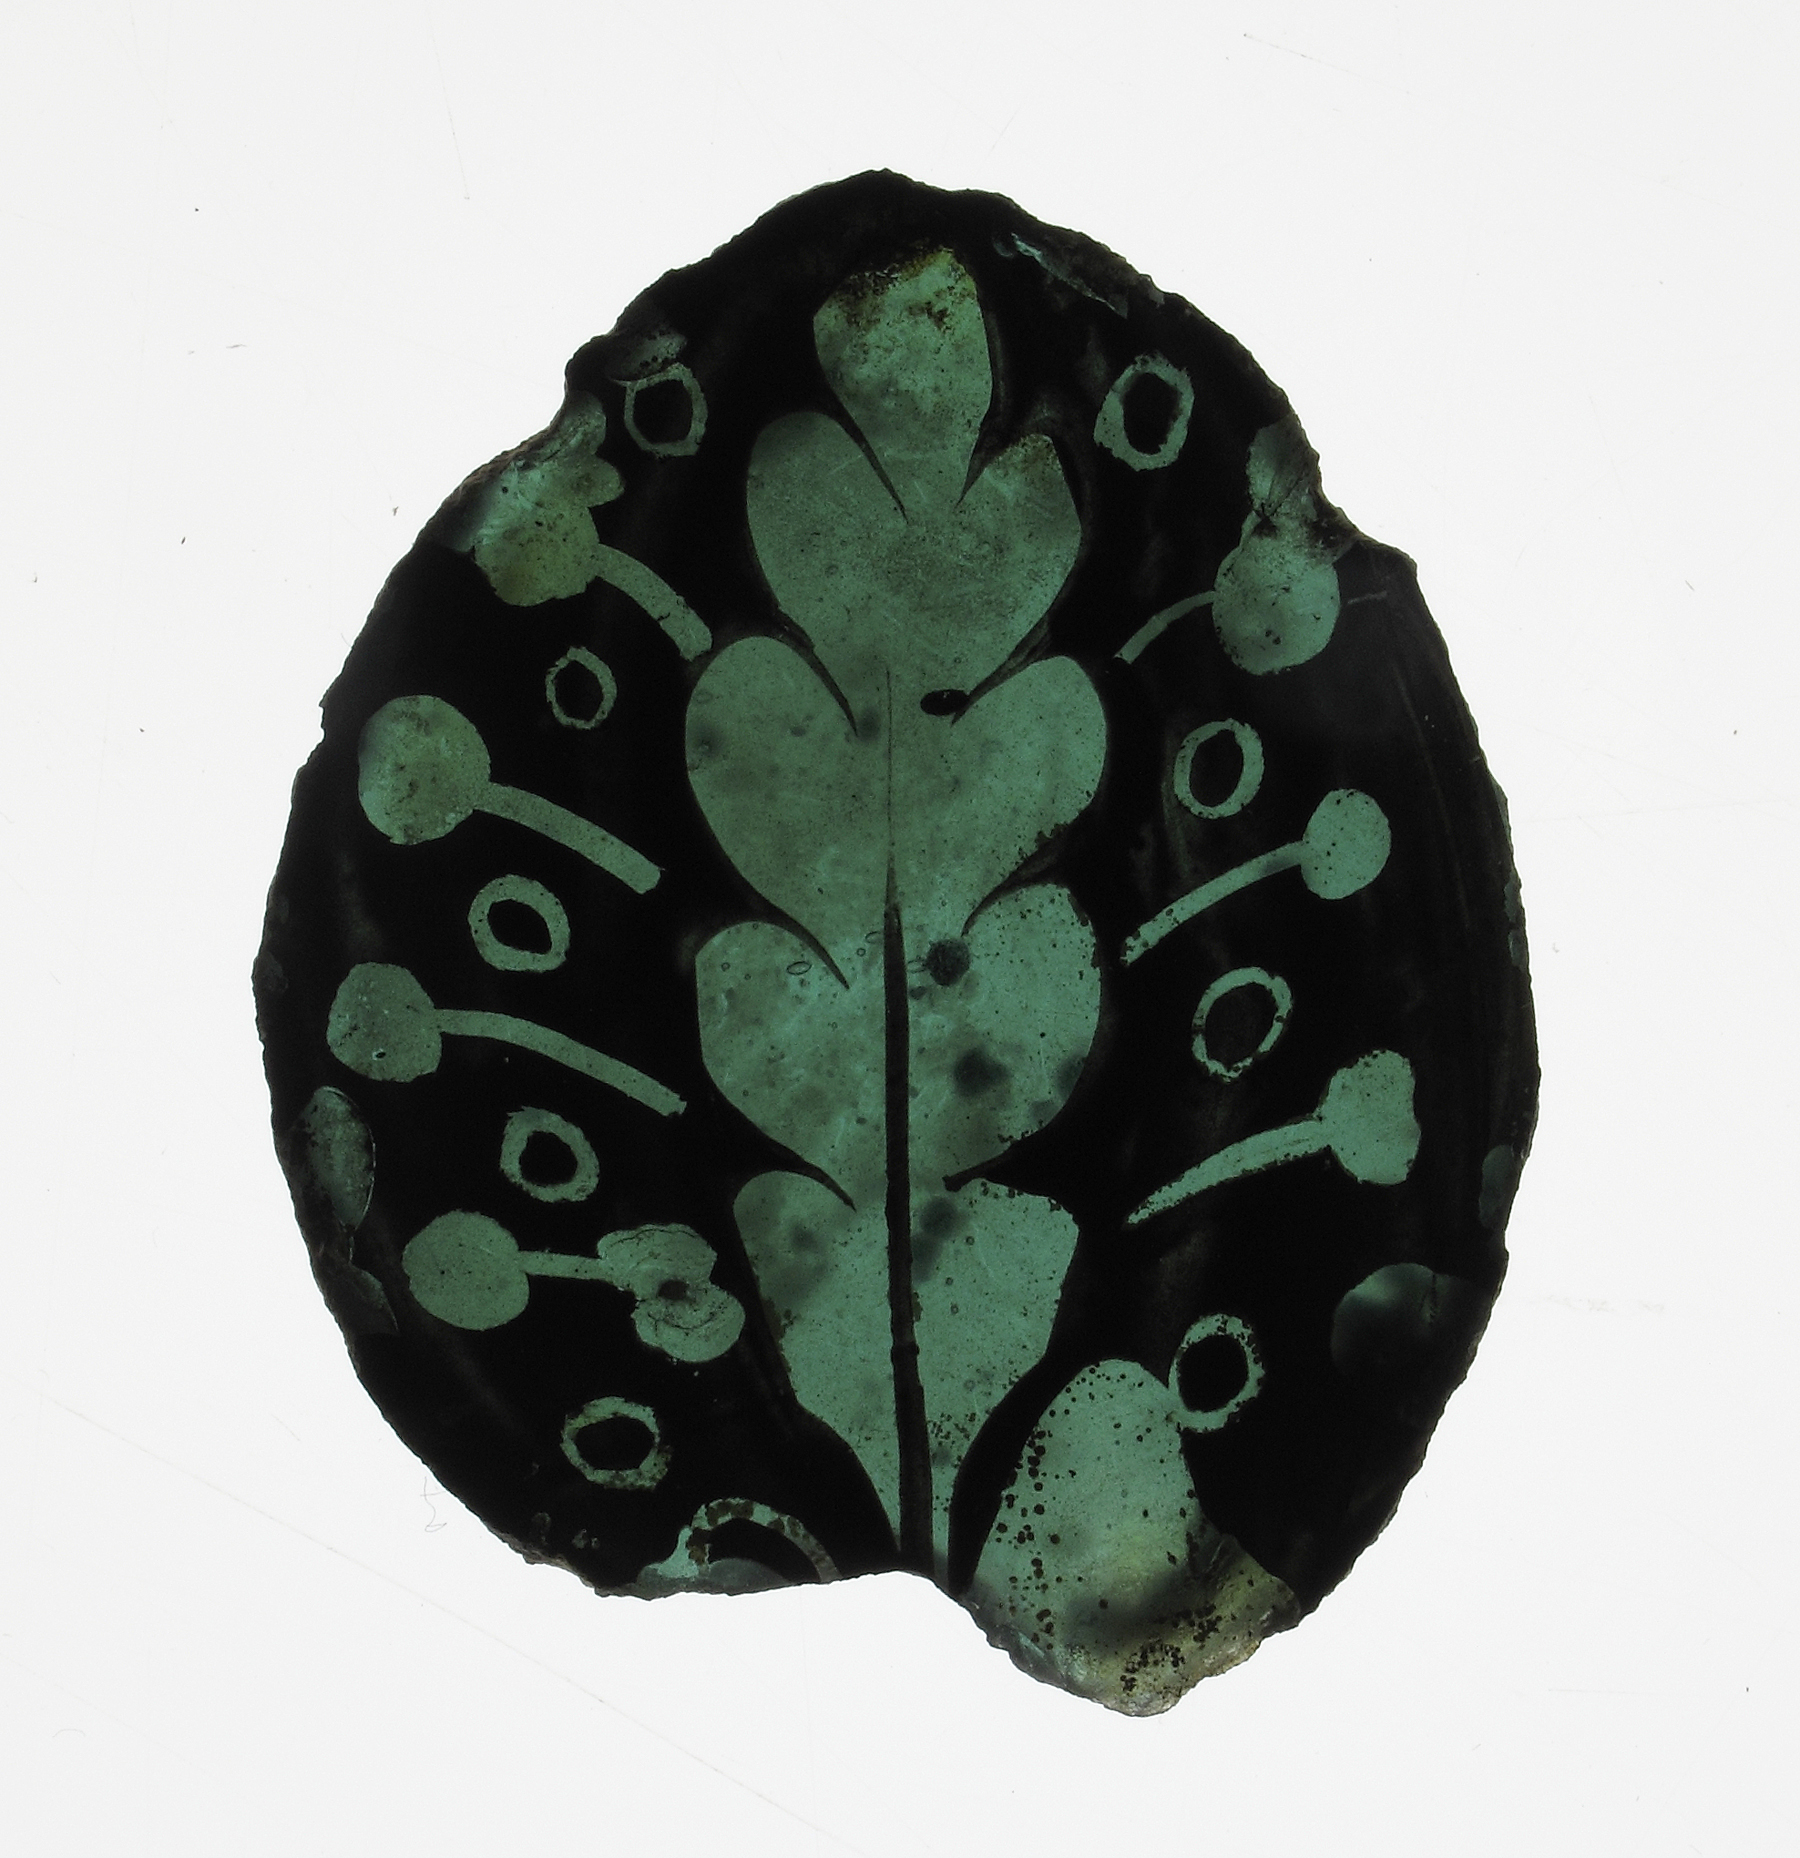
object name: fragment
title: Glass Fragment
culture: european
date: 1301-1500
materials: glass, metal